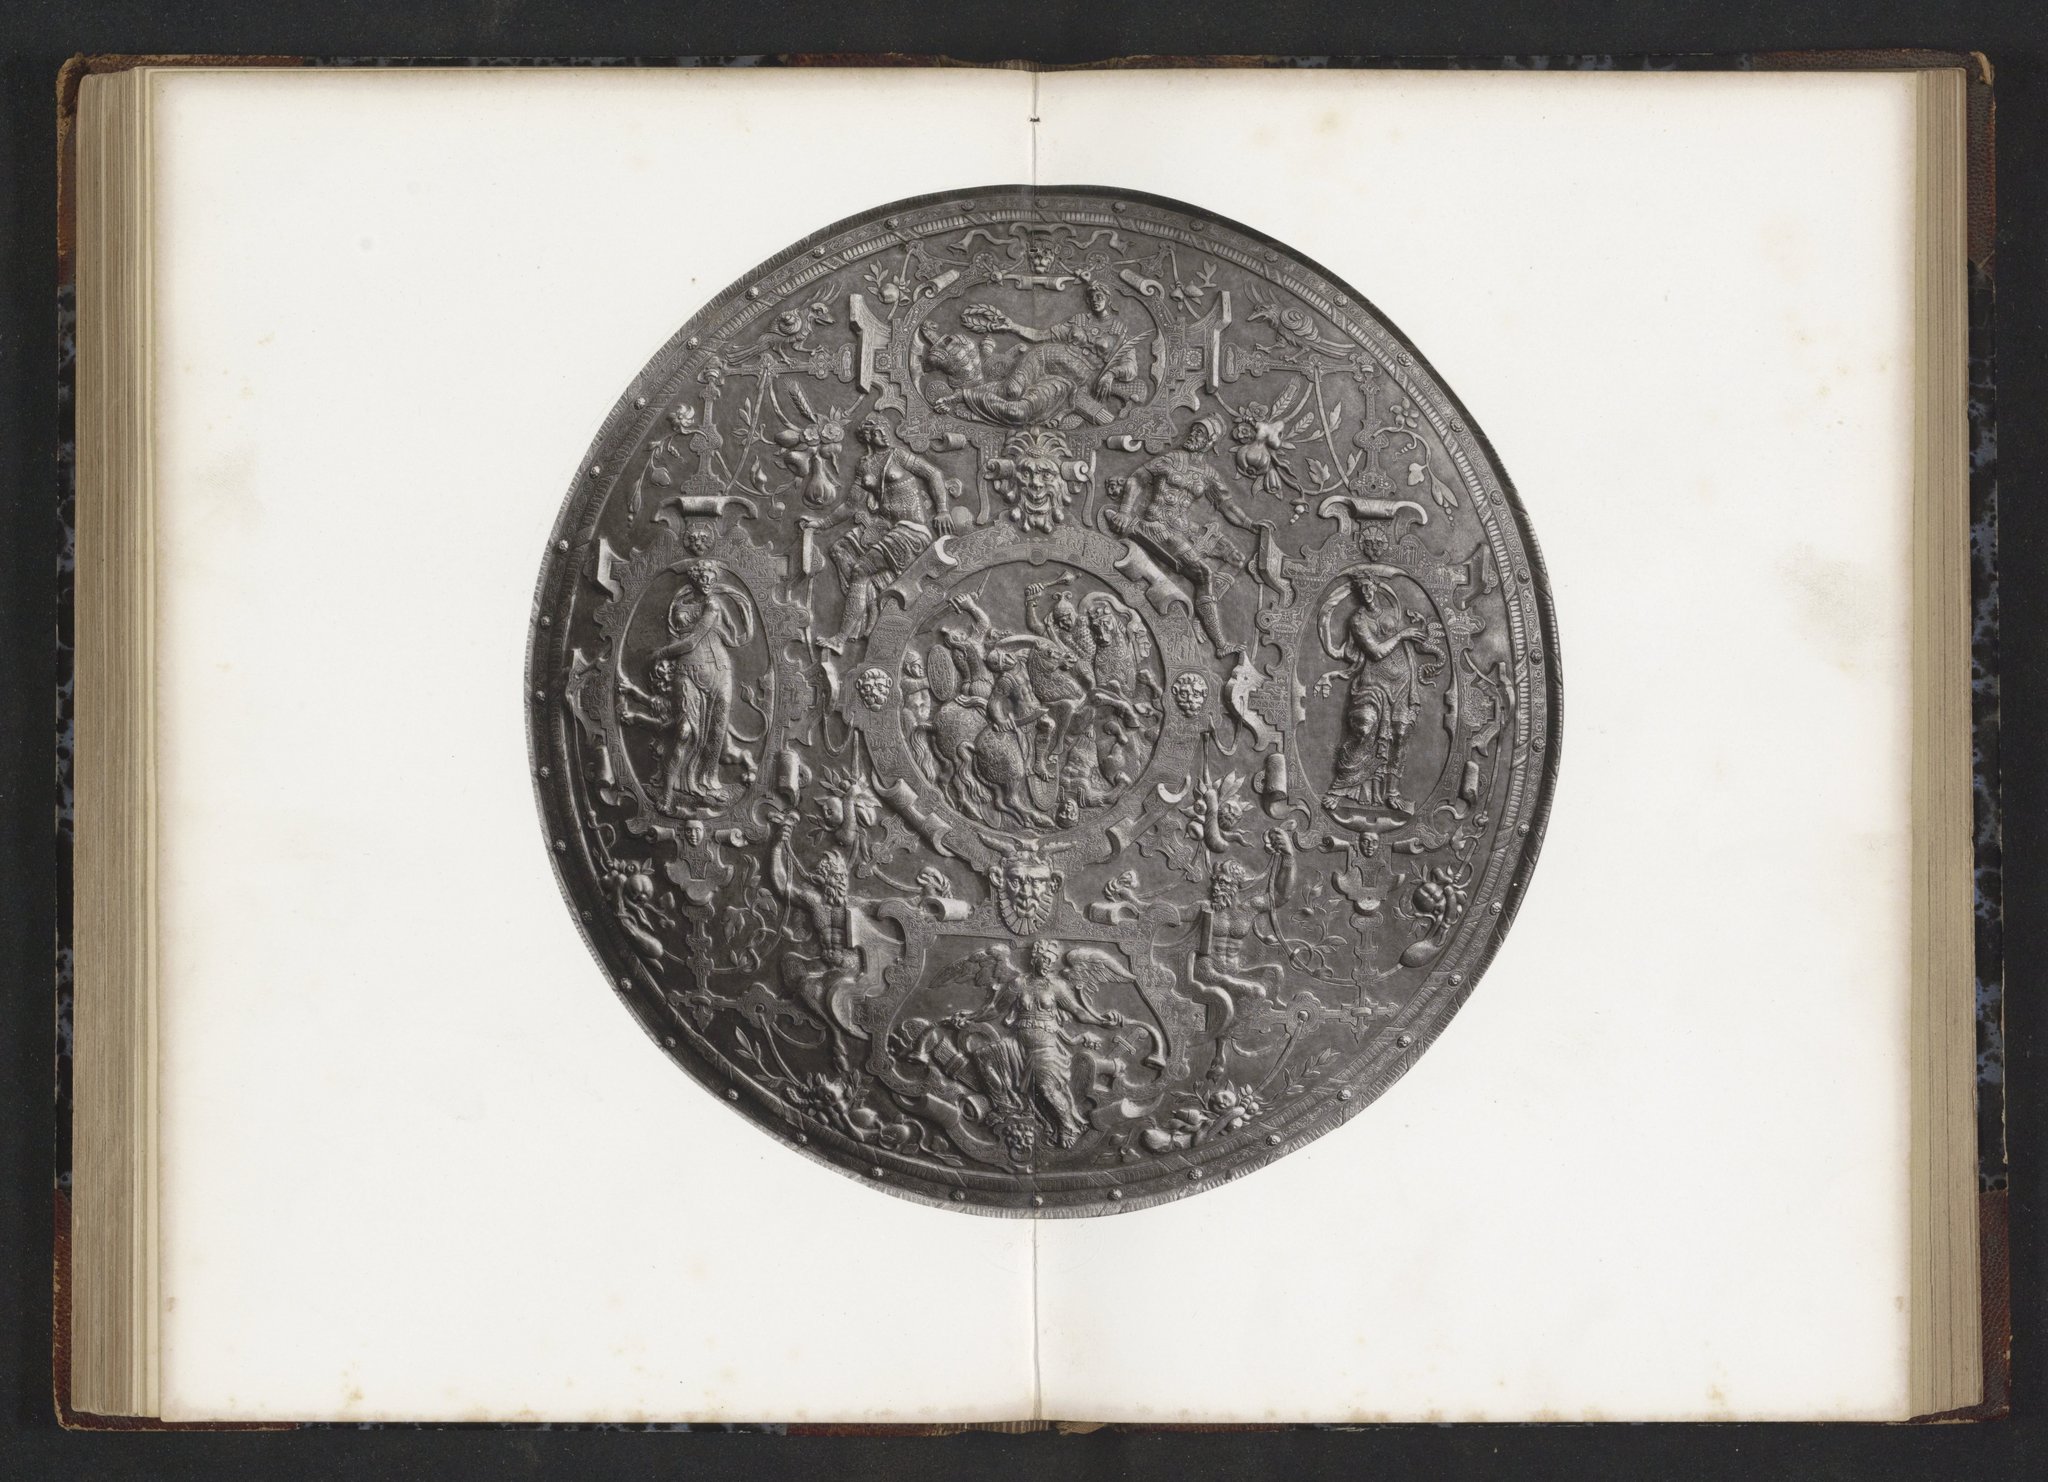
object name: photomechanical print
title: Schild gedecoreerd met reliëf voorstellingen van allegorieën op de glorie, de roem, de kracht en voorzichtigheid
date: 1870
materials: paper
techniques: woodburytype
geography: paris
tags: protective weapons: shield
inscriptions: name: ‘De Goupil & Cie Imp. Photoglytique Paris’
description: Volgens de beschrijving is het schild gesigneerd met: Georgius de Ghisys, Mantuanu, FA, MDLIIII.